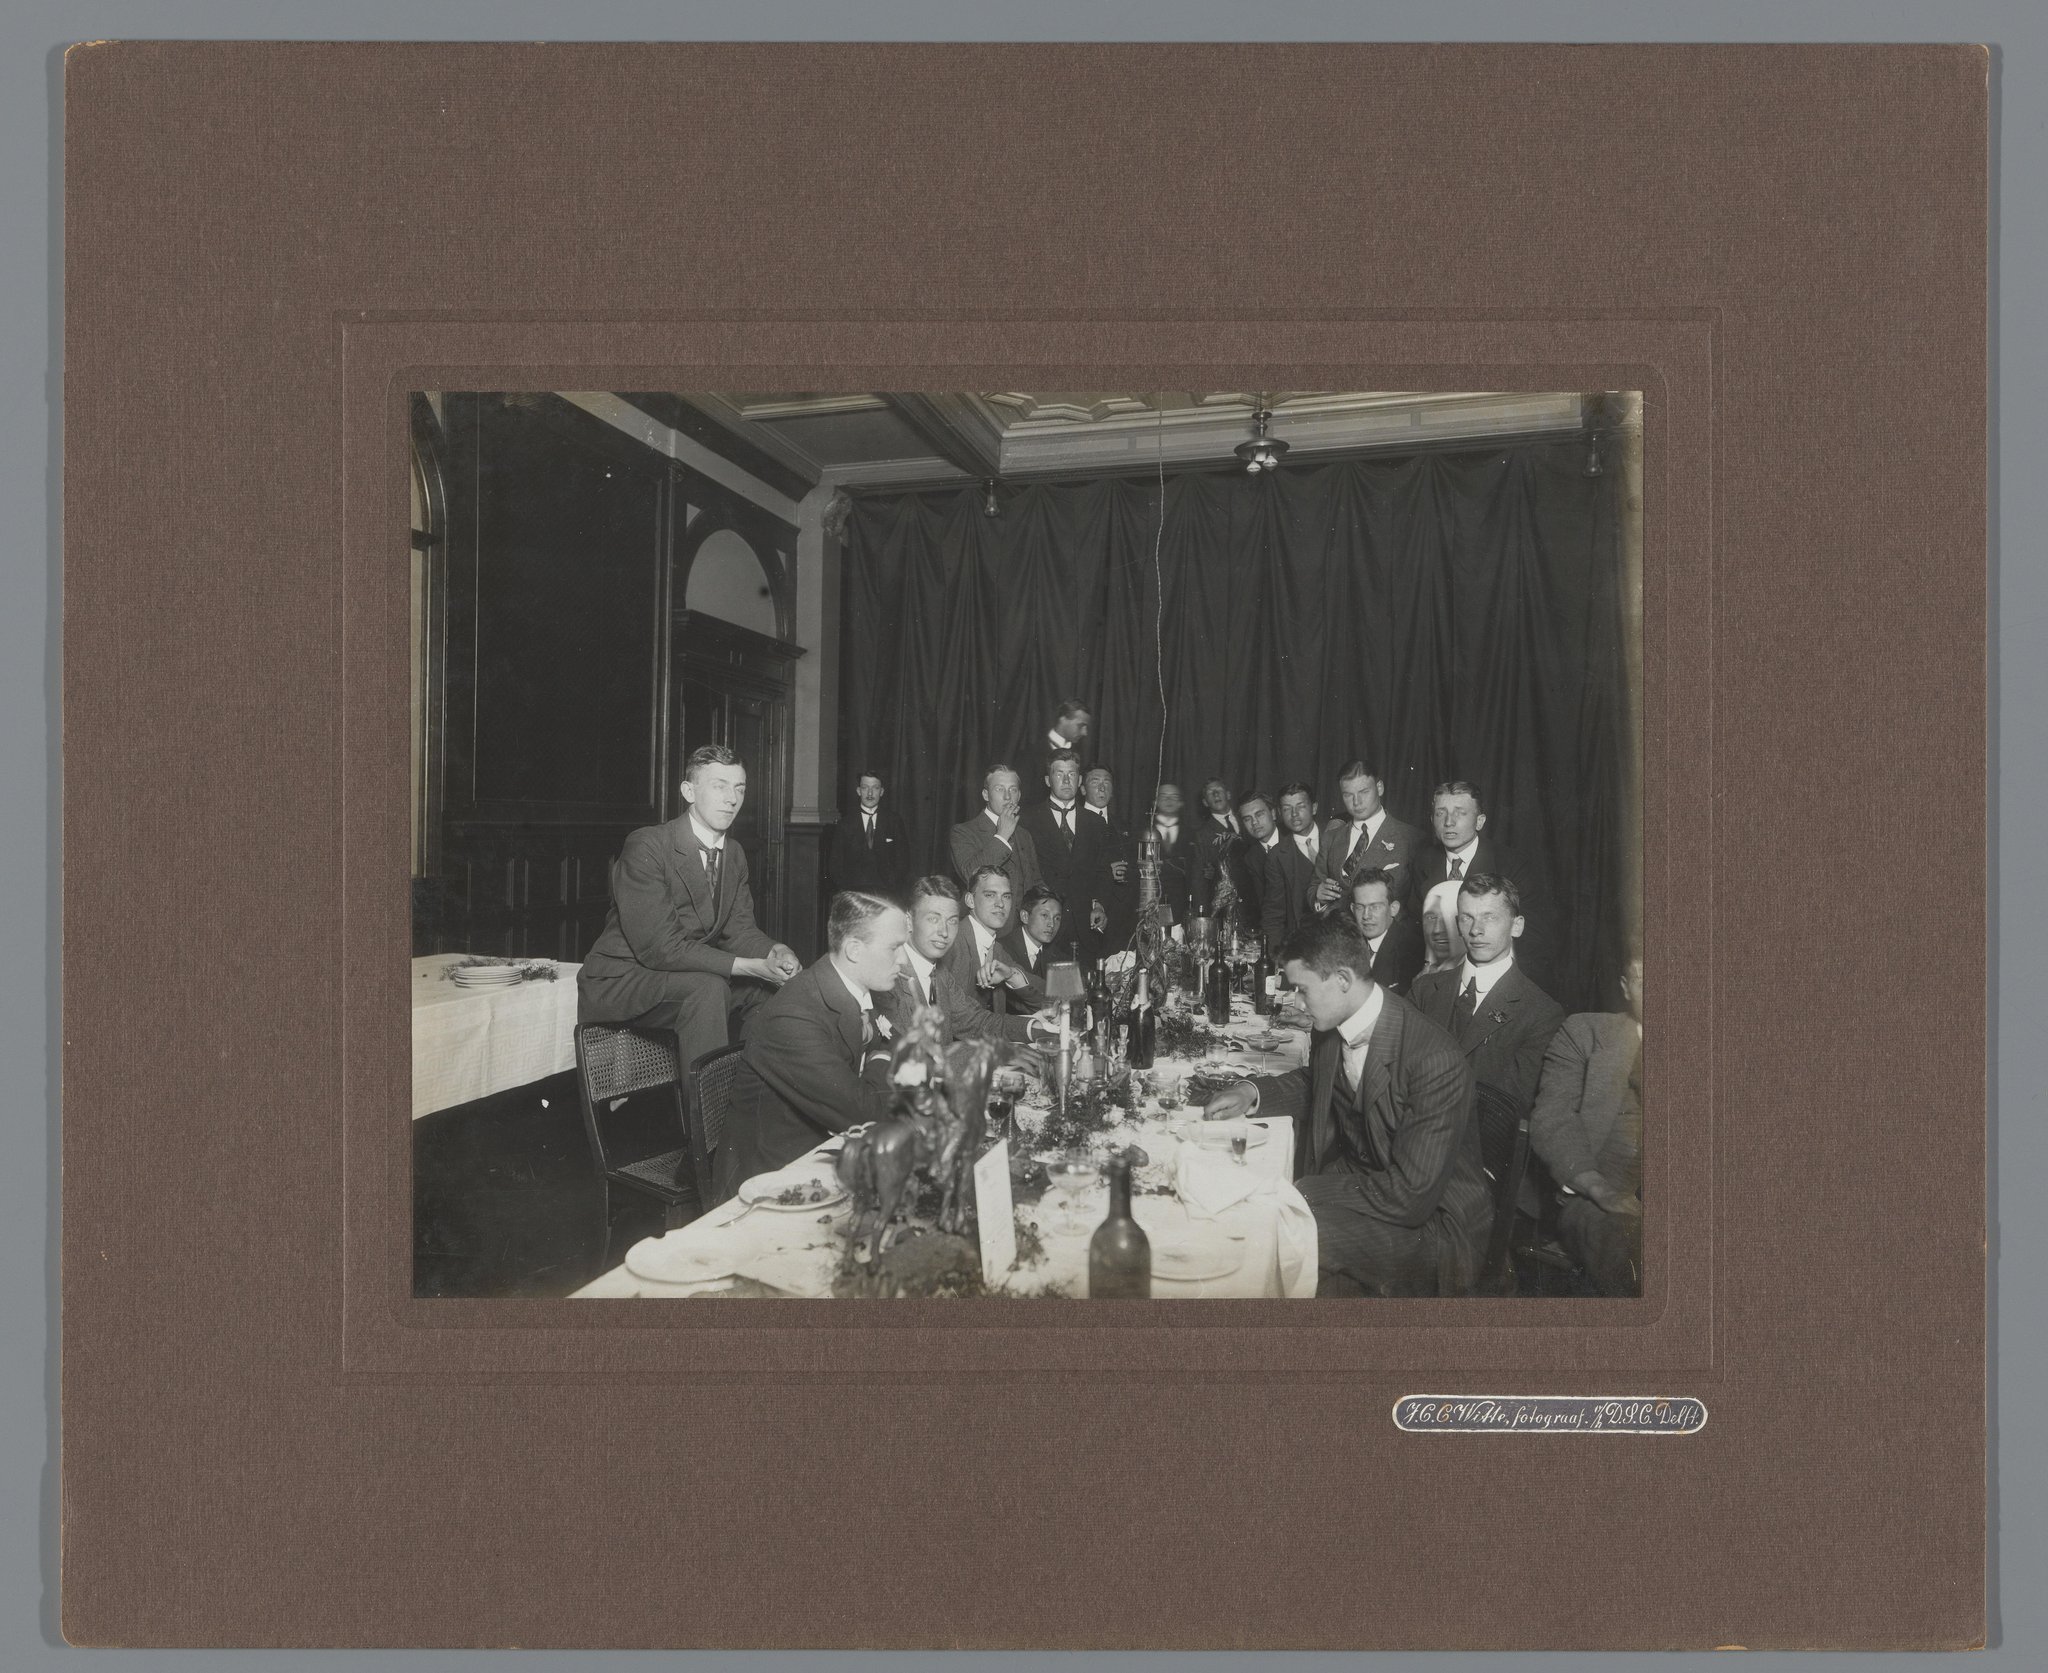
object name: photograph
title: Groepsportret van leden van roeivereniging Laga tijdens een diner op de sociëteit van het Delftsch Studenten Corps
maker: j.c.c. witte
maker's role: fotograaf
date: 1917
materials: paper, cardboard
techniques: gelatin silver print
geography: delft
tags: rowing facing backward, pulling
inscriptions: inscription: ‘Laga 1917/ 29 Juni./ v.l.n.r./ A.M.M./ Tideman/ Heyting/ V.d. Vegte/ [...]/ Guldenaar/ Boele/ Termijtelen/ Gerst/ de Vries/ Vist/ Amerschot/ Kennel./ Bolderdijk/ Groenemeer/ Polis/ vooraan. Berenschot/ Spillemaan Bilgen/ Staring.’